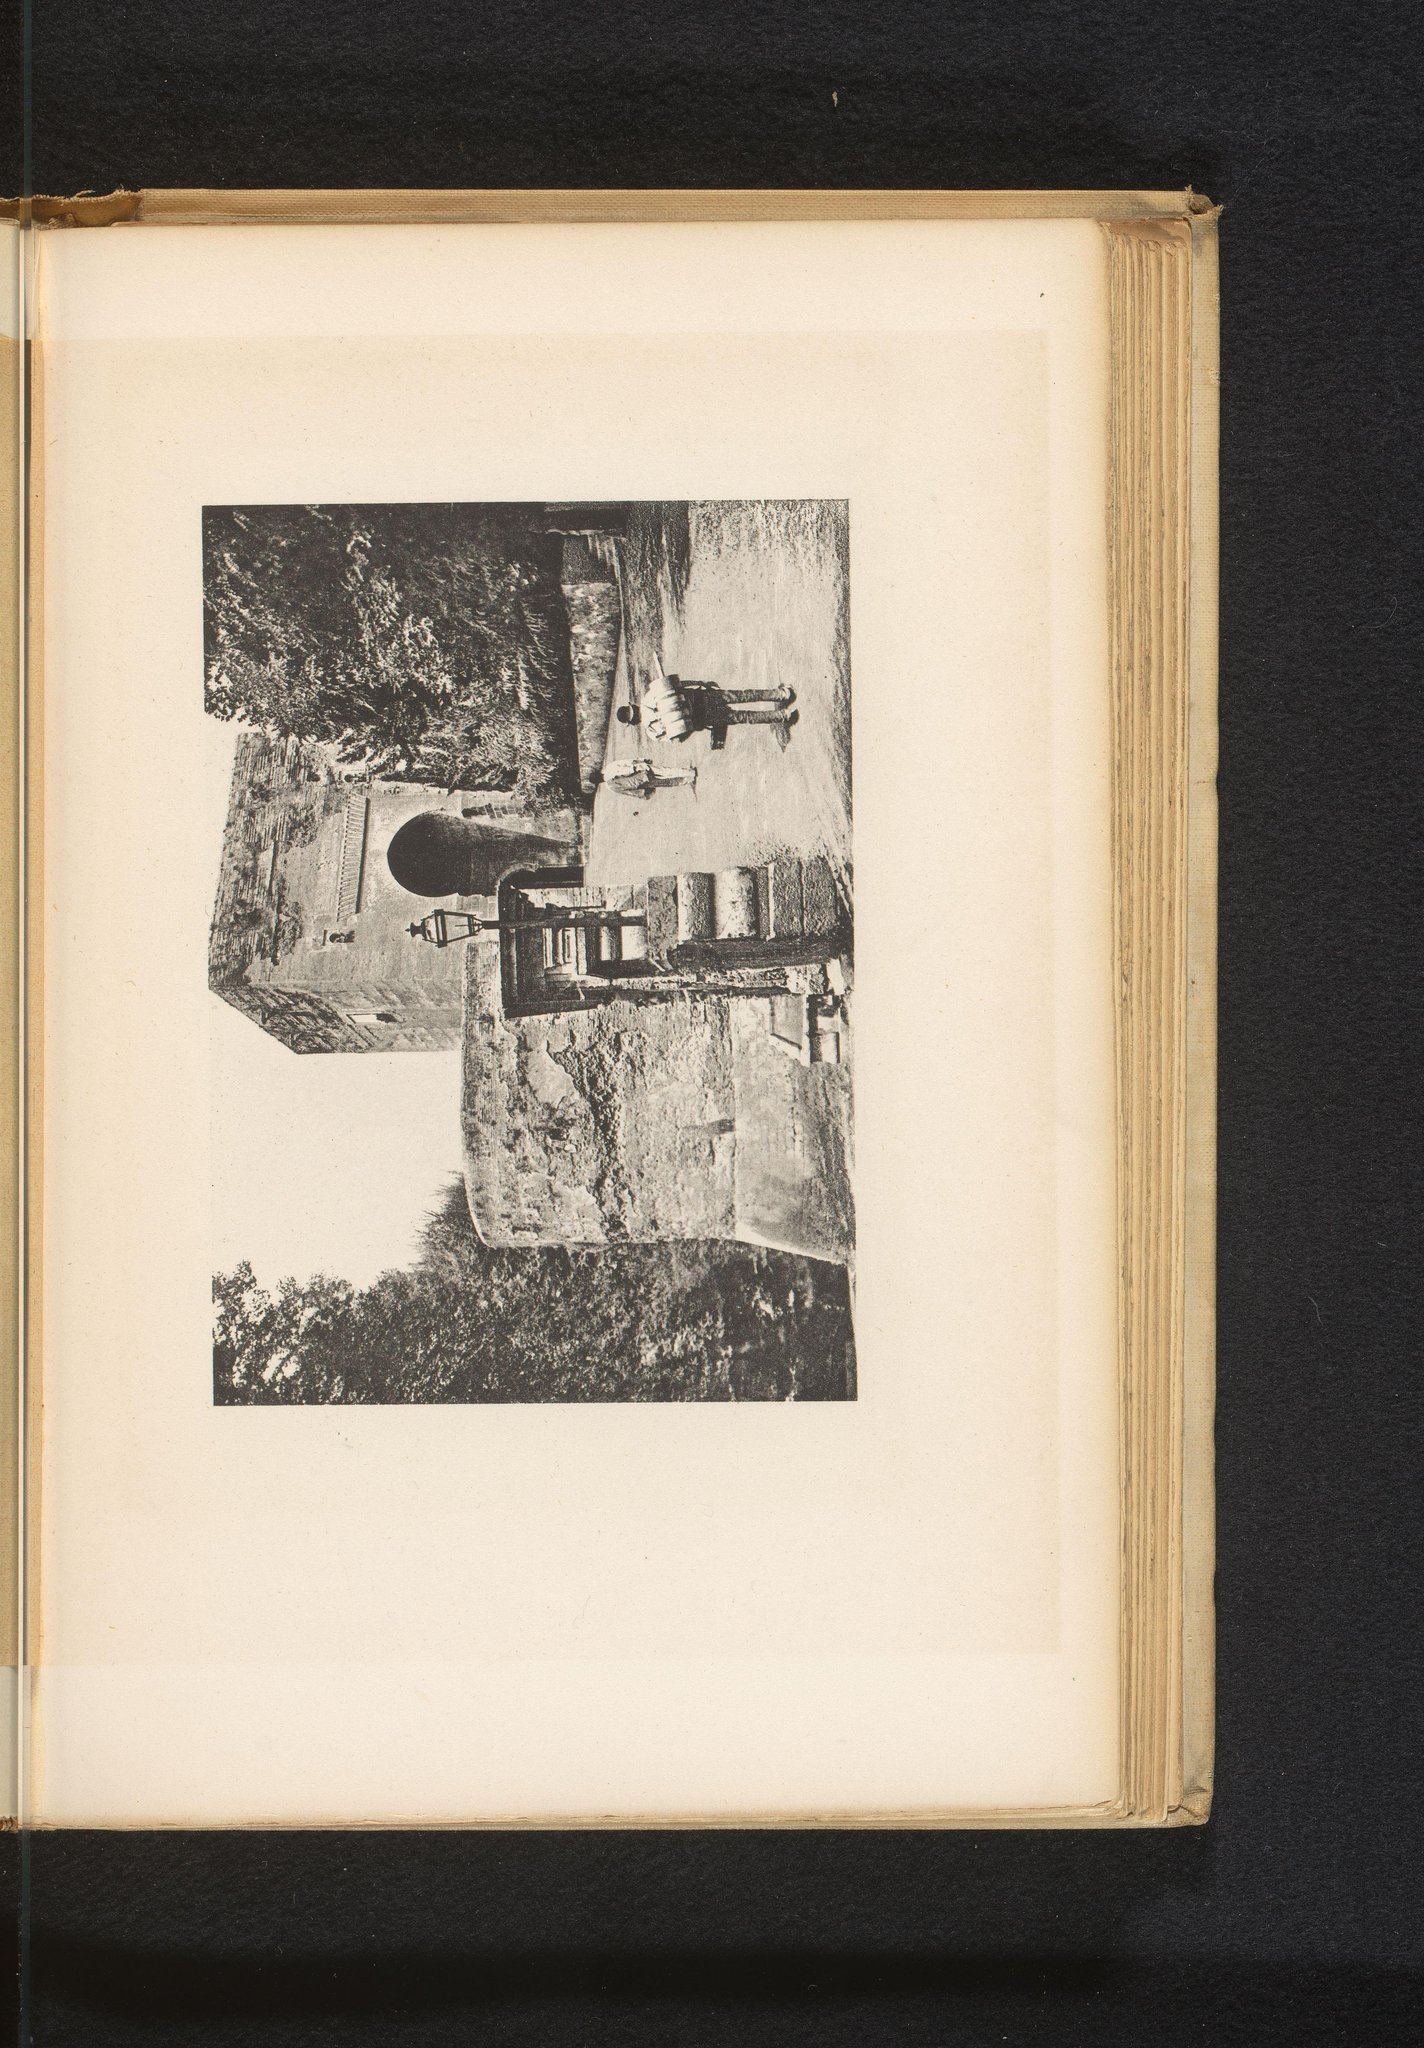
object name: page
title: Puerta del Juicio-the Entrance to the Enclosure of the Alhambra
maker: Anonymous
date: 1884-1894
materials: paper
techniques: photoaquatint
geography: granada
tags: gate, entrance